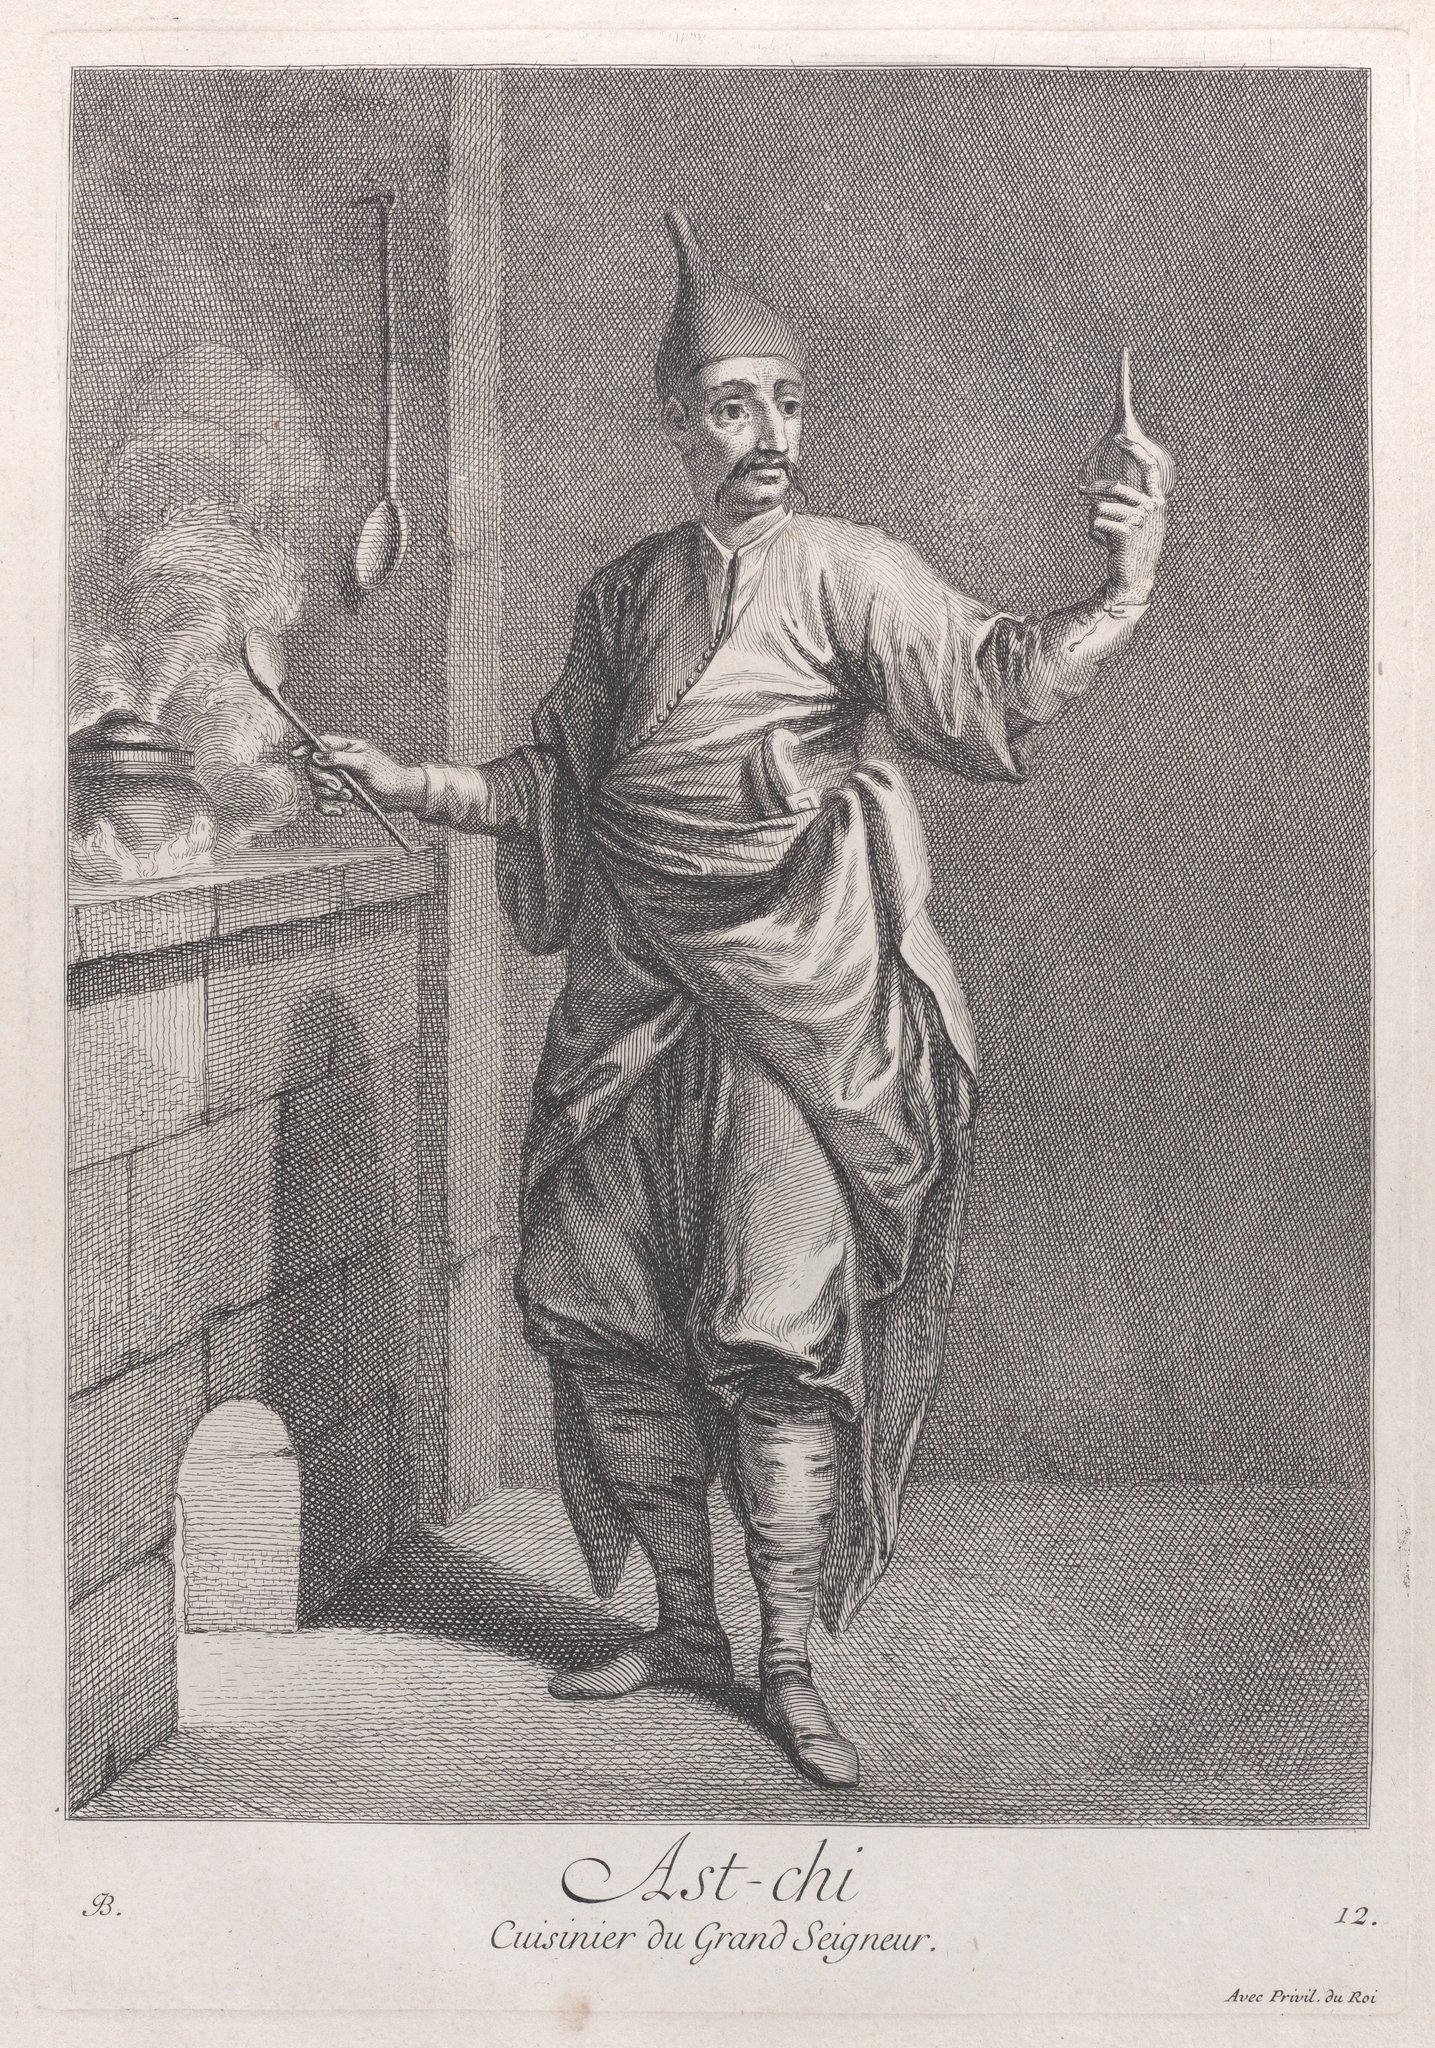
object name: print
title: Ast-chi, Cuisinier du Grand Seigneur, plate 12 from "Recueil de cent estampes représentent differentes nations du Levant"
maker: jean baptiste vanmour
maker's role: artist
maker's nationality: french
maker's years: 1671-1737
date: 1714-1715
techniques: engraving, etching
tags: men